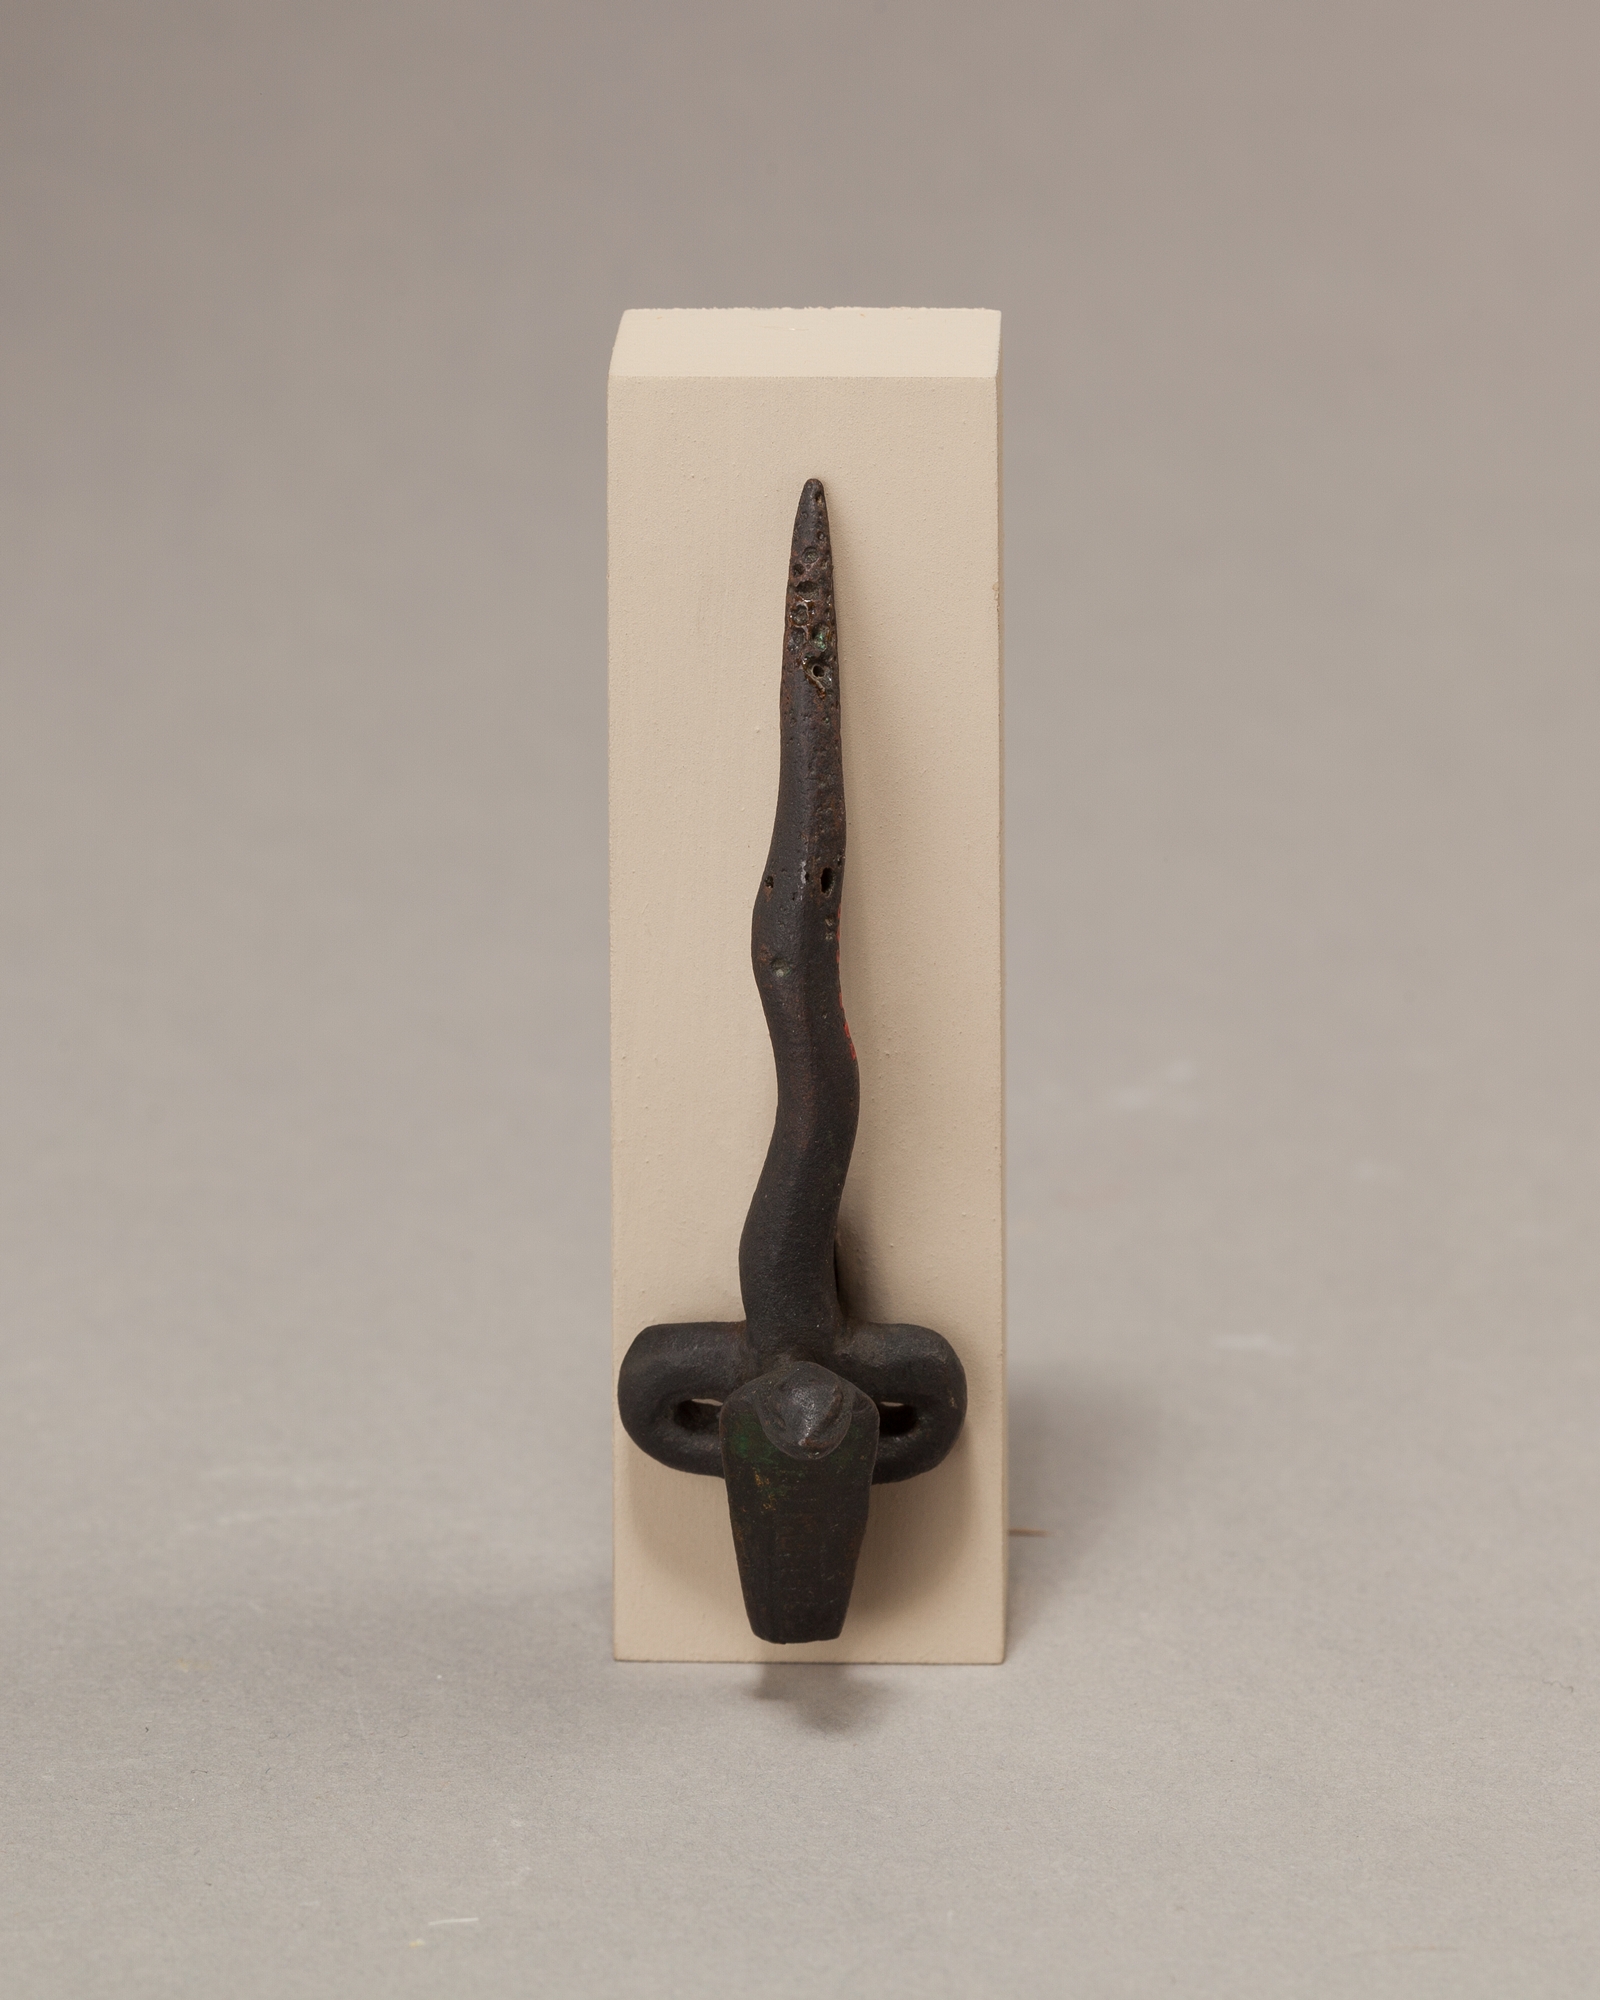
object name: headdress attachment, uraeus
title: Uraeus headdress attachment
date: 664-630 BCE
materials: metal, gold leaf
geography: egypt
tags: serpents